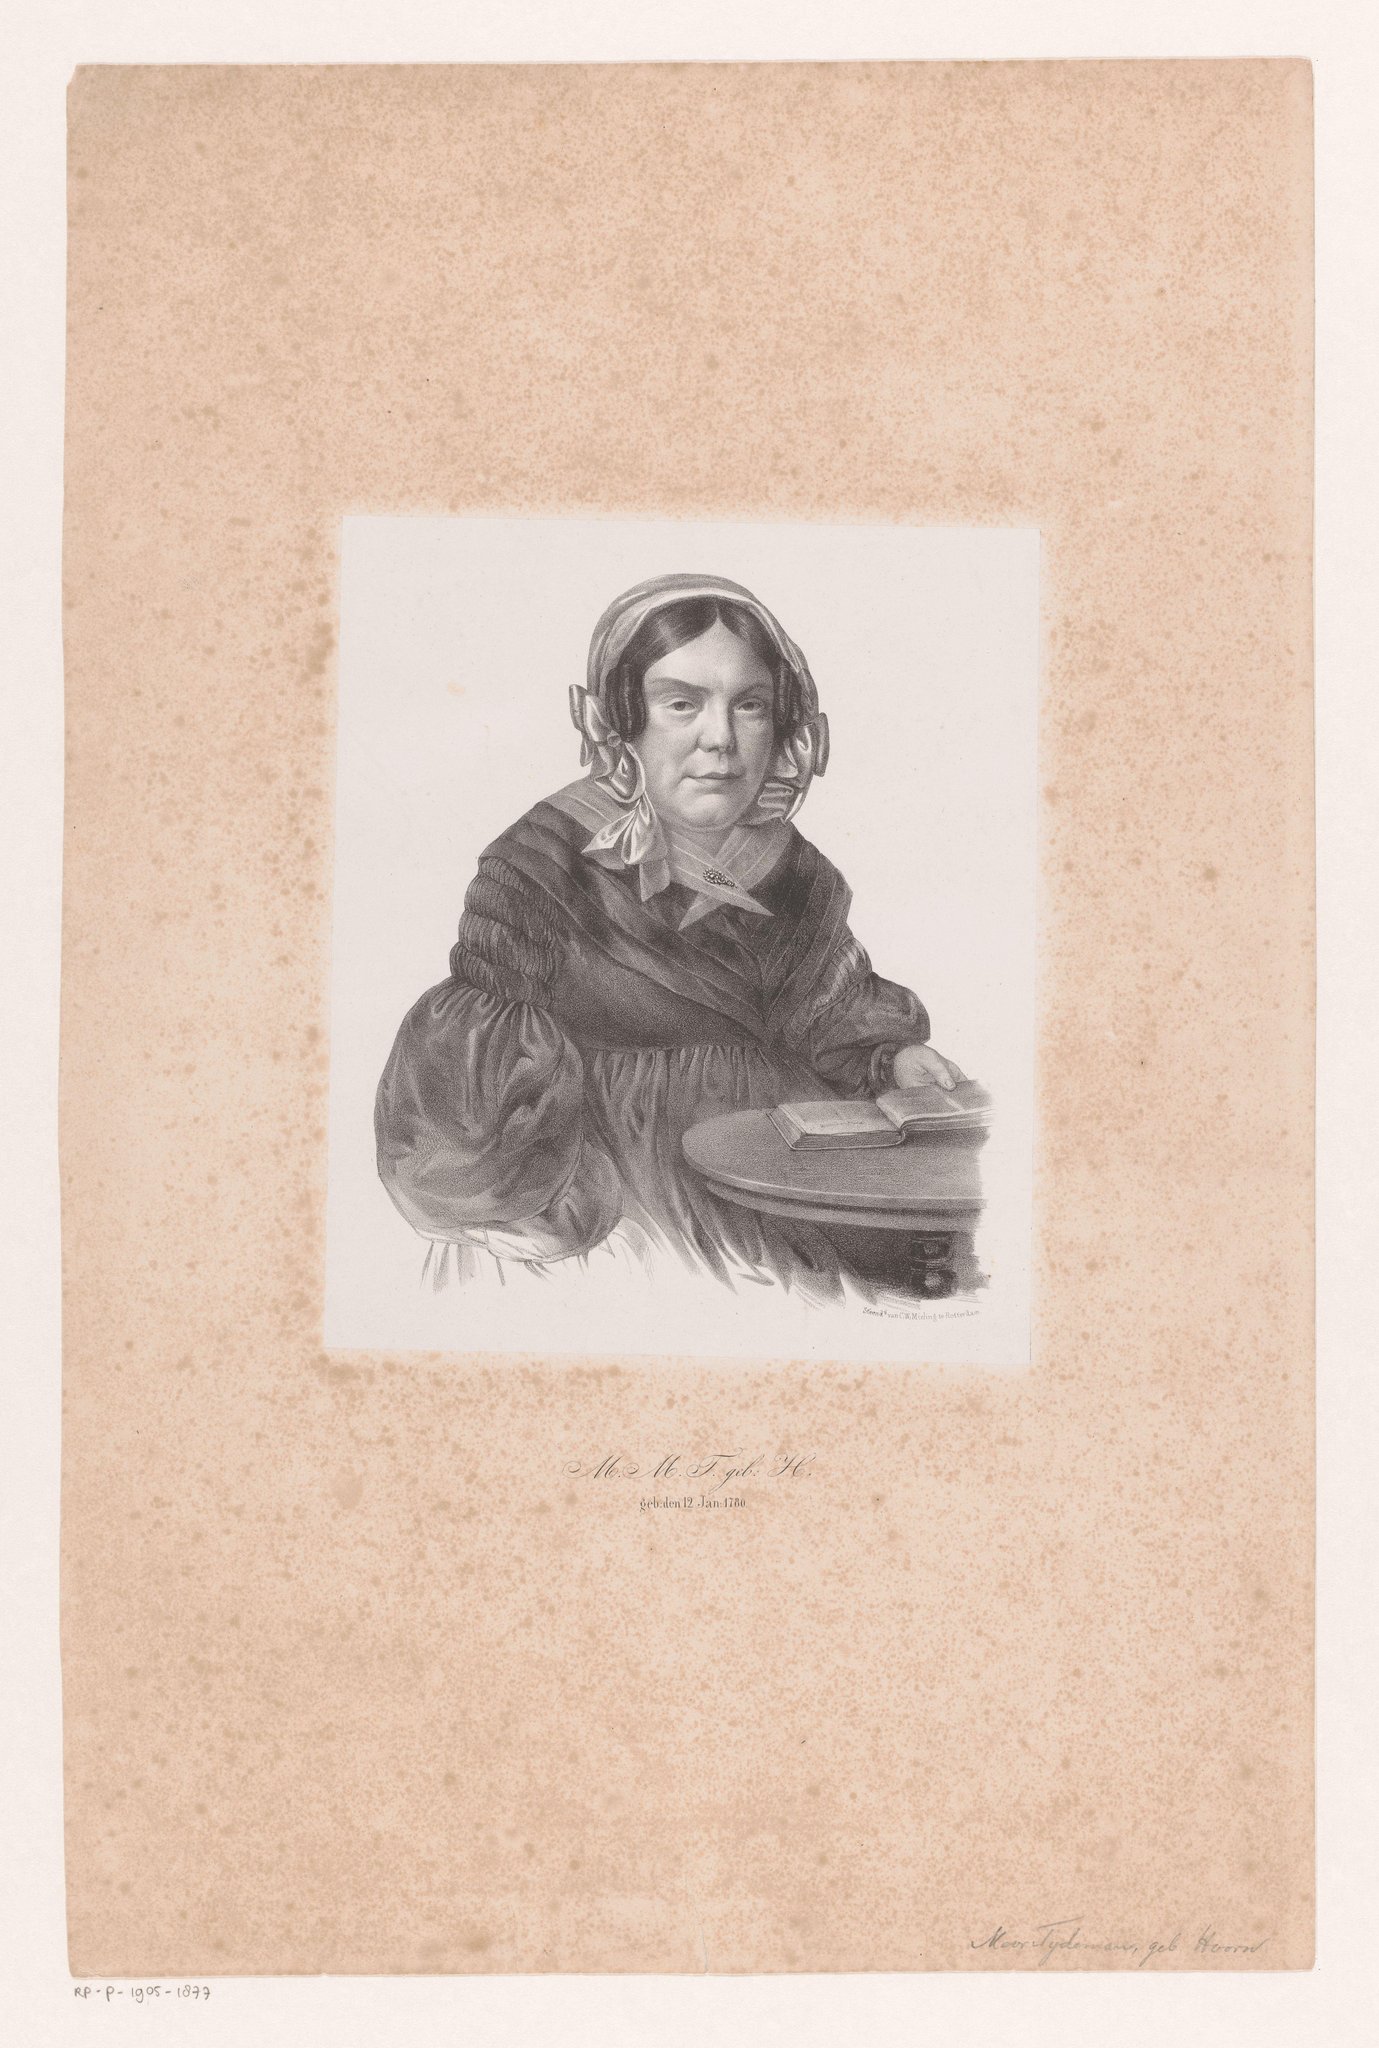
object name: print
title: Portret van Marianne Mathilda Hoorn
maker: Anonymous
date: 1839-1845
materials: paper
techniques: lithograph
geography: rotterdam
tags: book, historical persons (+ half-length portrait)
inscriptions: collector's mark: Lugt 2228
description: Marianne Mathilda Hoorn (12 januari 1780 - 21 april 1850) was de eerste vrouw van Hendrik Willem Tydeman (25 augustus 1778 Utrecht - 06 april 1863).